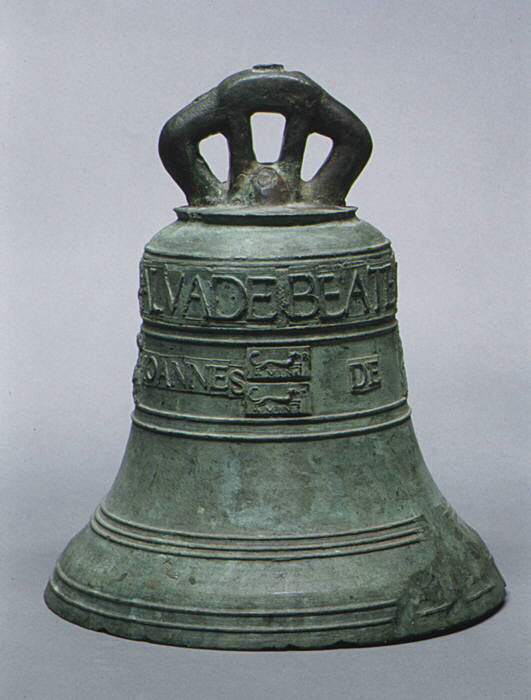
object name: church bell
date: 1597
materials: bronze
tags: human figures,musical instruments